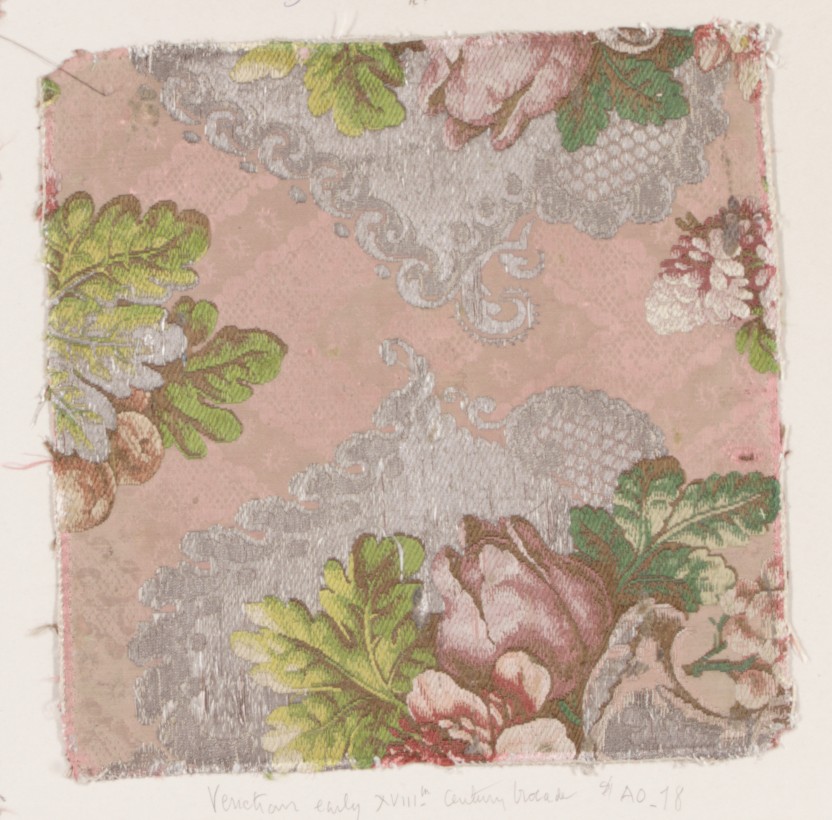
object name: fragment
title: Fragment of brocaded silk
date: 1701-1800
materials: metal thread, silk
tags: flowers,leaves